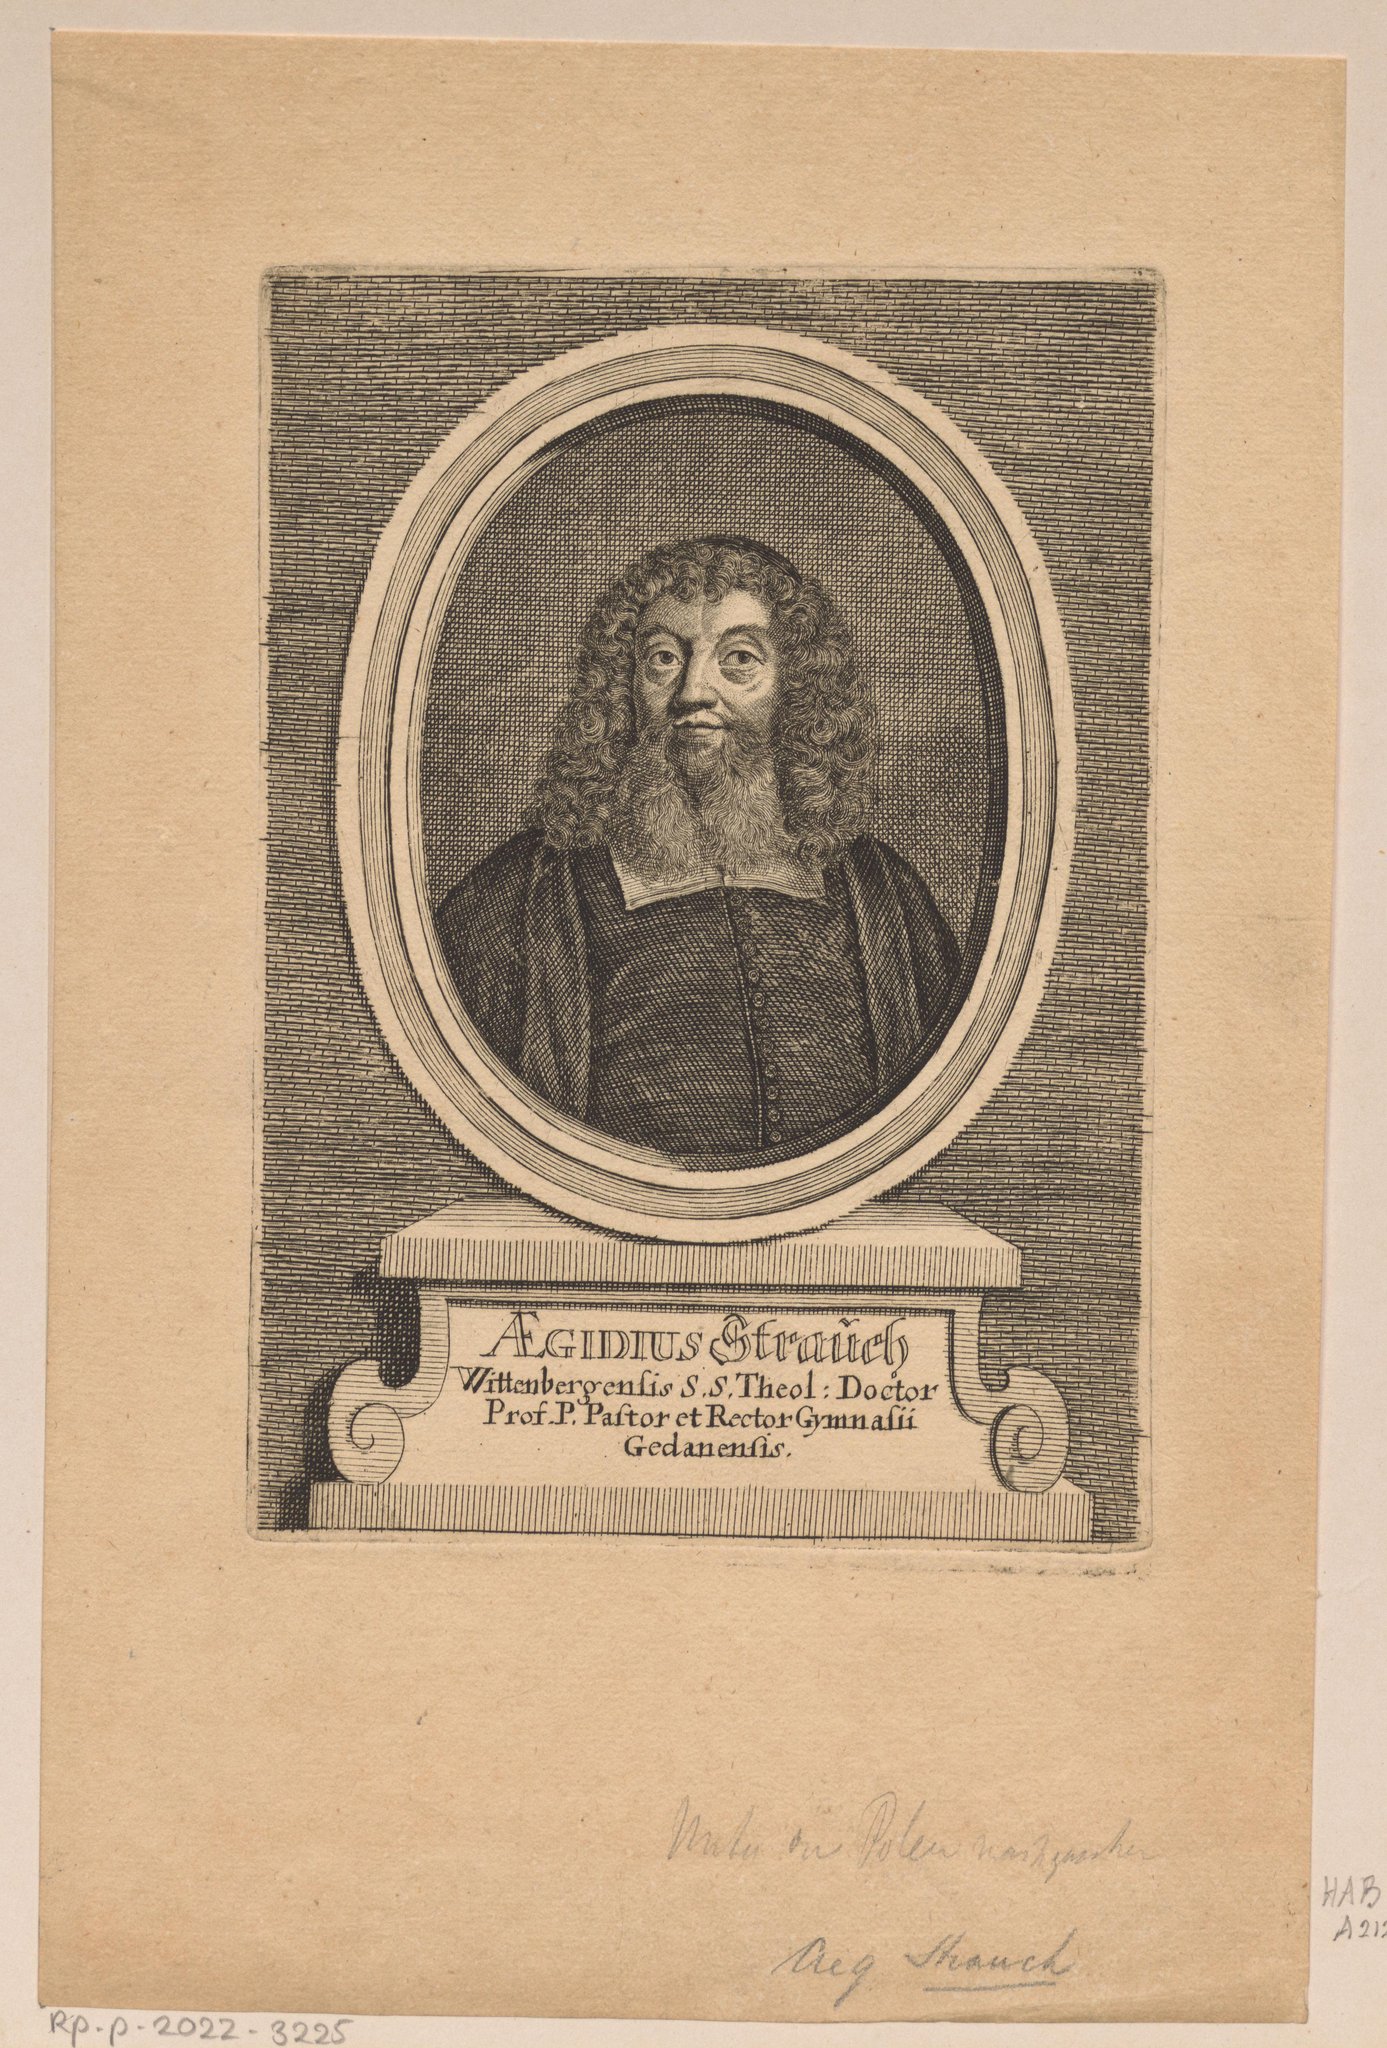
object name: print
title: Portret van Aegidius Strauch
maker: Anonymous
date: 1666-1699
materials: paper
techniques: engraving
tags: theologian, historical persons, mathematics (+ portrait of scholar, scientist)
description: Met drieregelig onderschrift in het Latijn.